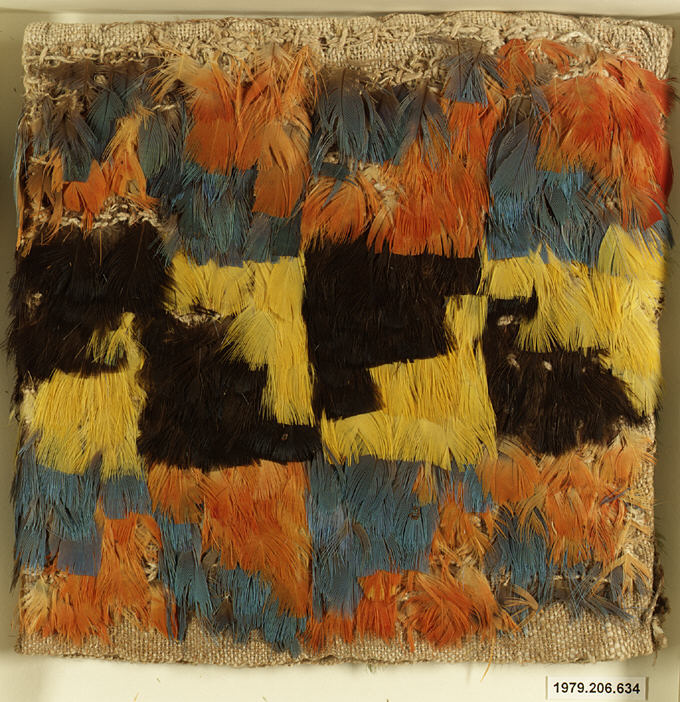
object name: miniature dress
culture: ica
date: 1101-1300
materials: cotton, feather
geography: peru